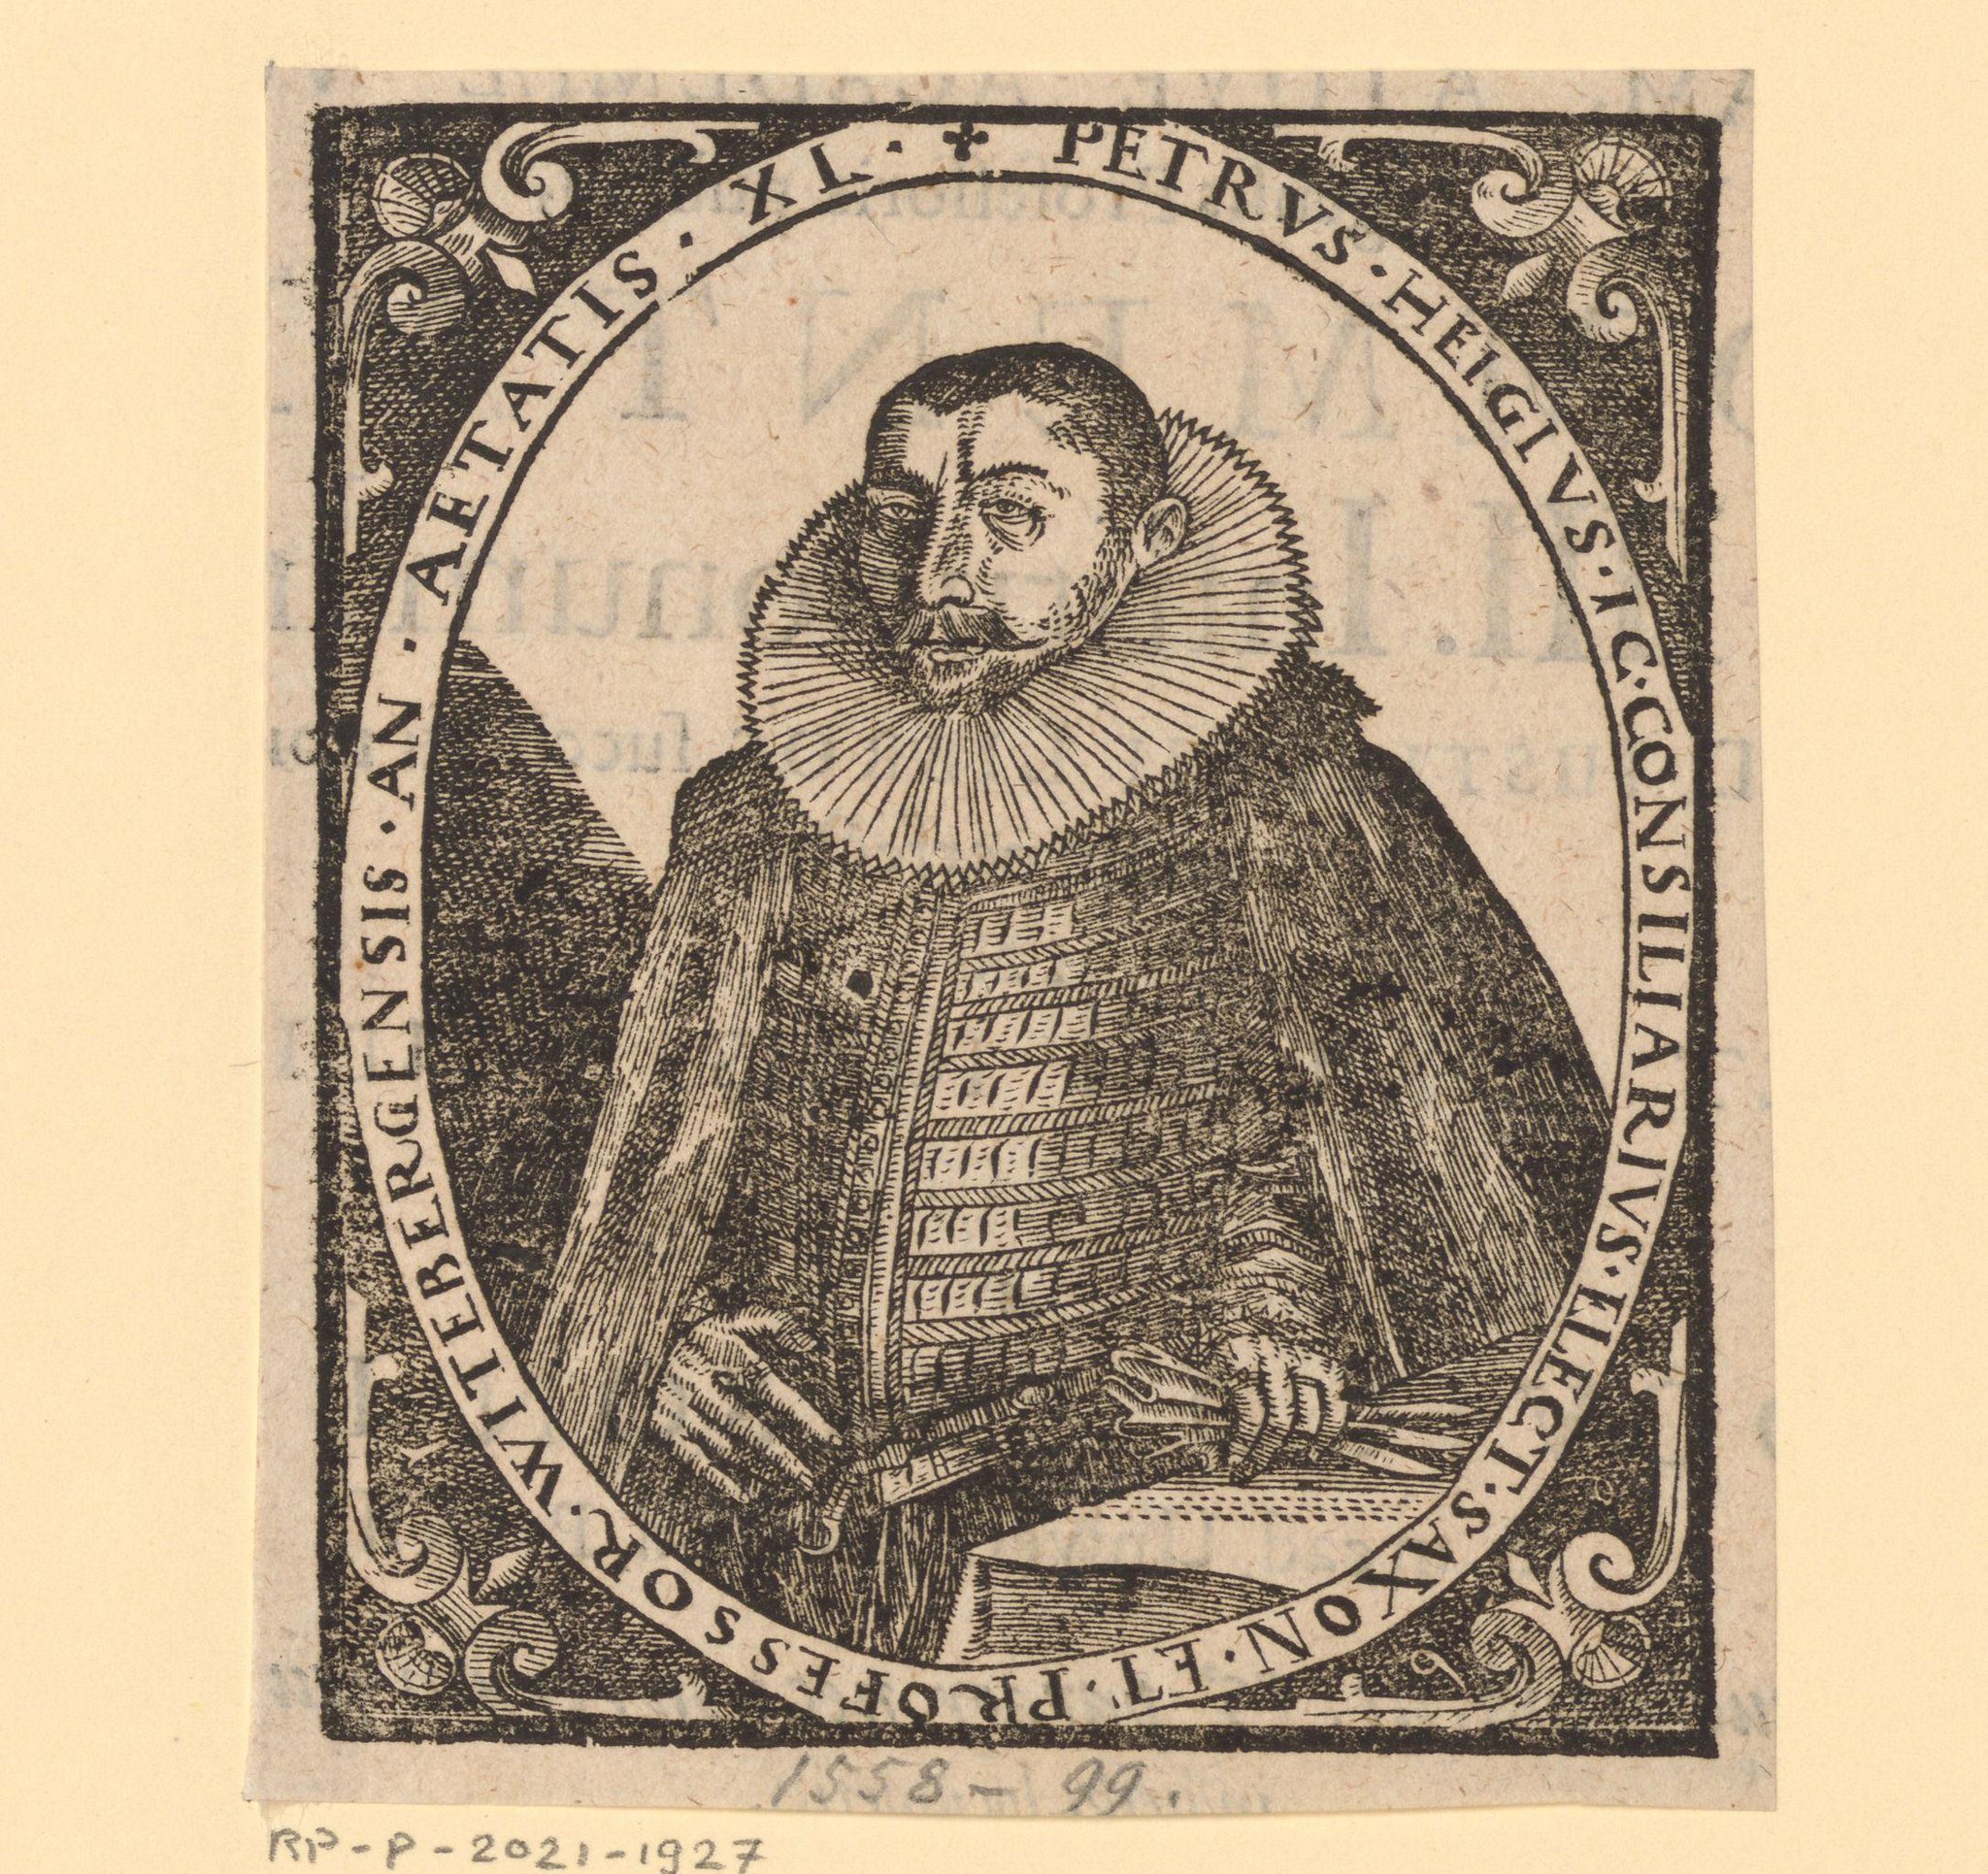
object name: book illustration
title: Portret van Peter Heige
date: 1603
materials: paper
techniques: letterpress printing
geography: wittenberg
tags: scholar, philosopher, historical persons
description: Prent uit: Heige, Peter. Commentarii super IIII institutionum imperialium D. Justiniani libros (...). Wittenberg: Lorenz Säuberlich, 1603.